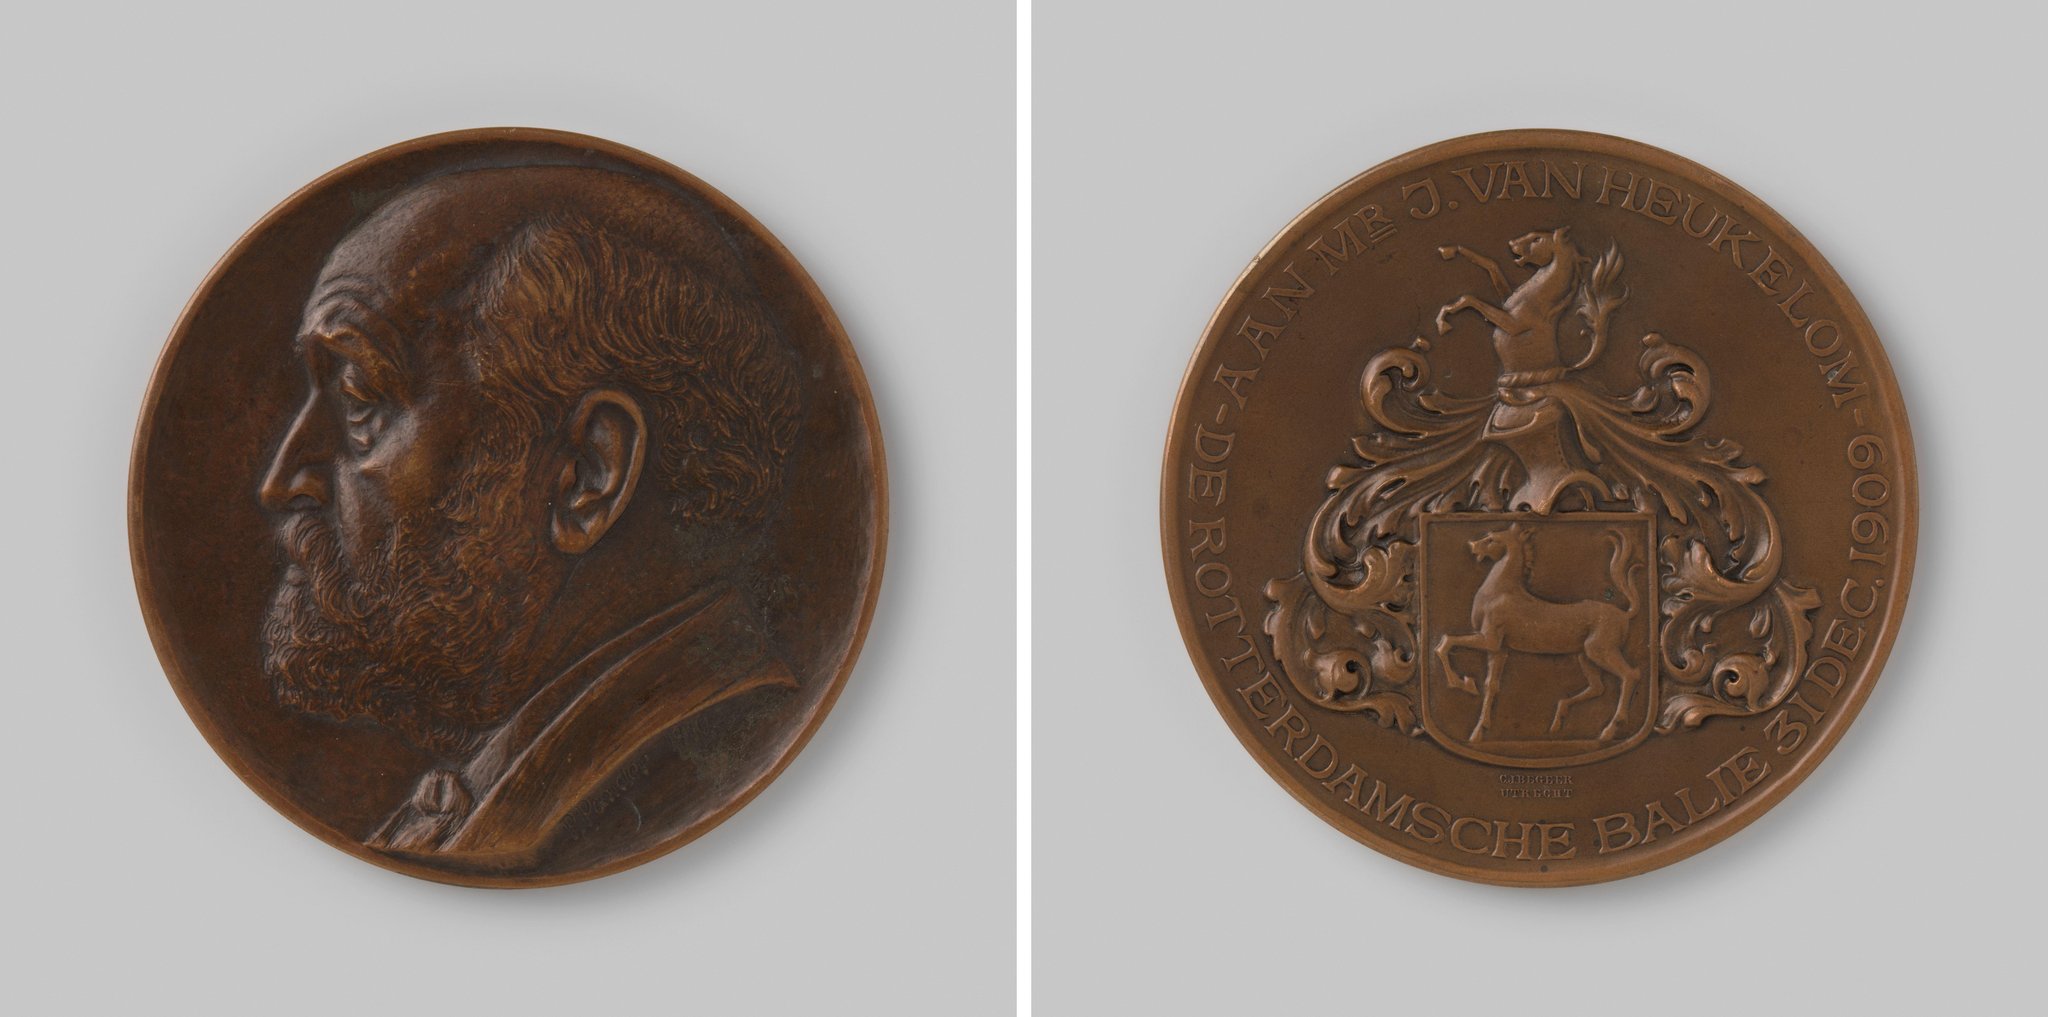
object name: history medal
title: Portretpenning van J. van Heukelom 1909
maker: pier pander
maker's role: designer, draughtsman, sculptor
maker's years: 1864-1919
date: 1909-1910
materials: bronze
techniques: striking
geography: utrecht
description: Bronzen penning, op de voorzijde het portret van Van Heukelom naar links, op de keerzijde een gehelmd wapenschild met omschrift.